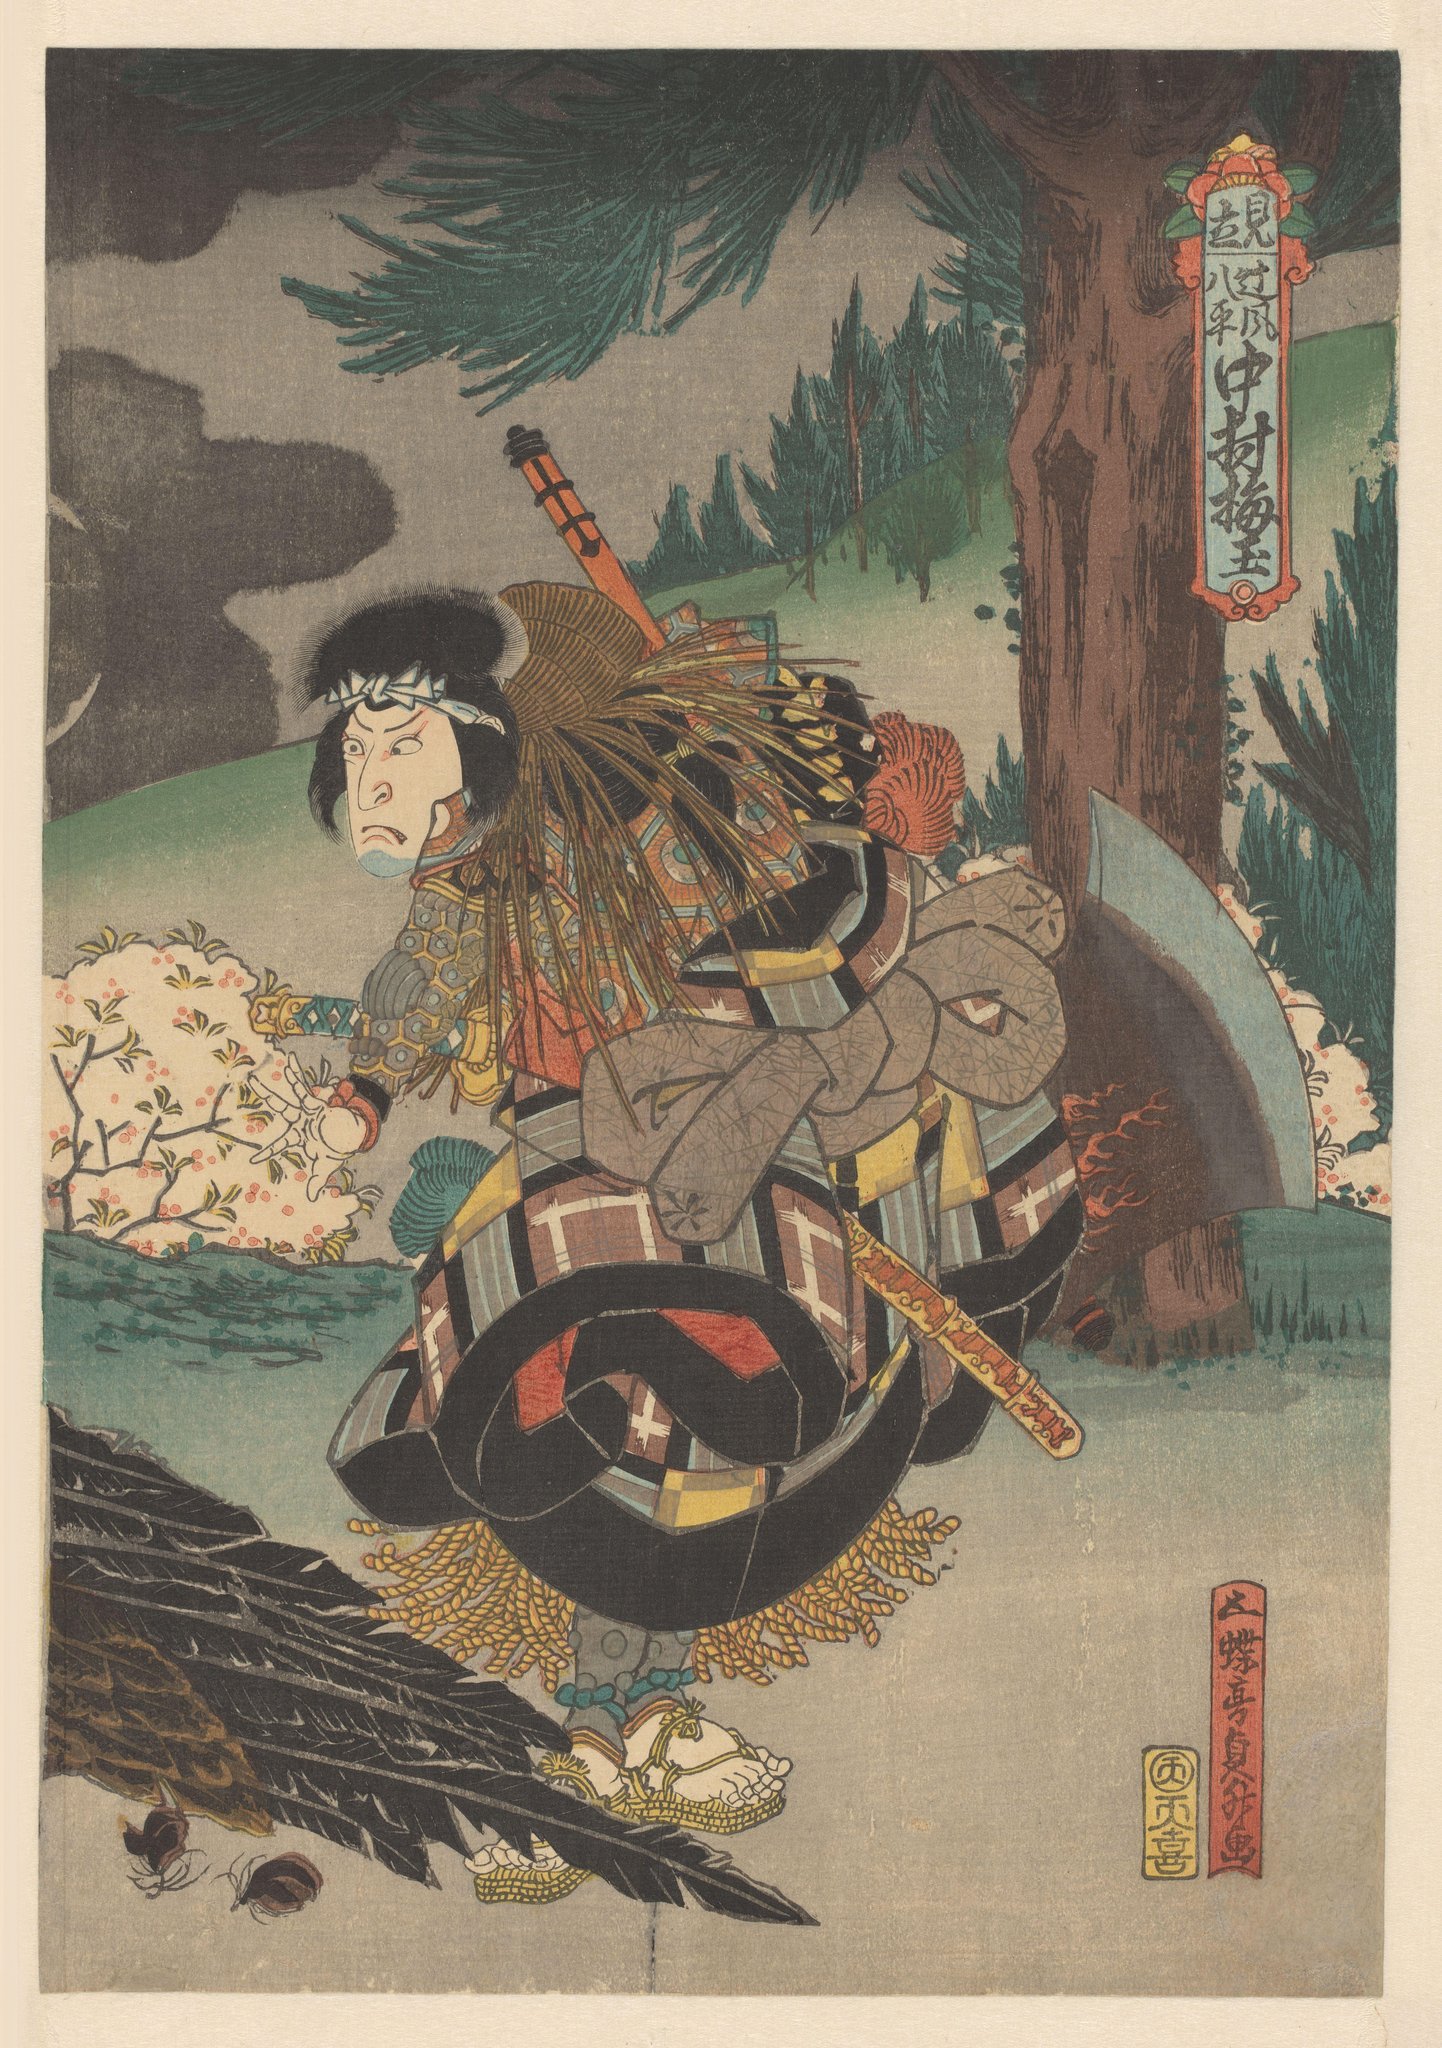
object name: print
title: Vierluik met vier toneelspelers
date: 1834-1835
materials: paper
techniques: woodcut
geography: osaka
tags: adult man, hacking and thrusting weapons: sword, landscapes (+ landscape with figures, staffage)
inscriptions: mark: ‘Tenki’, signature: ‘Gochôtei Sadamasu ga’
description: Rechter blad van een vierluik v.l.n.r. Iwai Shijaku I als Inaba, Nakamura Shikan II als Inaba Tarô, Arashi Rikan II als Ushiwaka Saburô, en Nakamura Baigyoku I (Nakamura Utaemon III) als Tsujikaze Happei. In het midden van de scène ligt een reusachtige, overwonnen roofvogel.